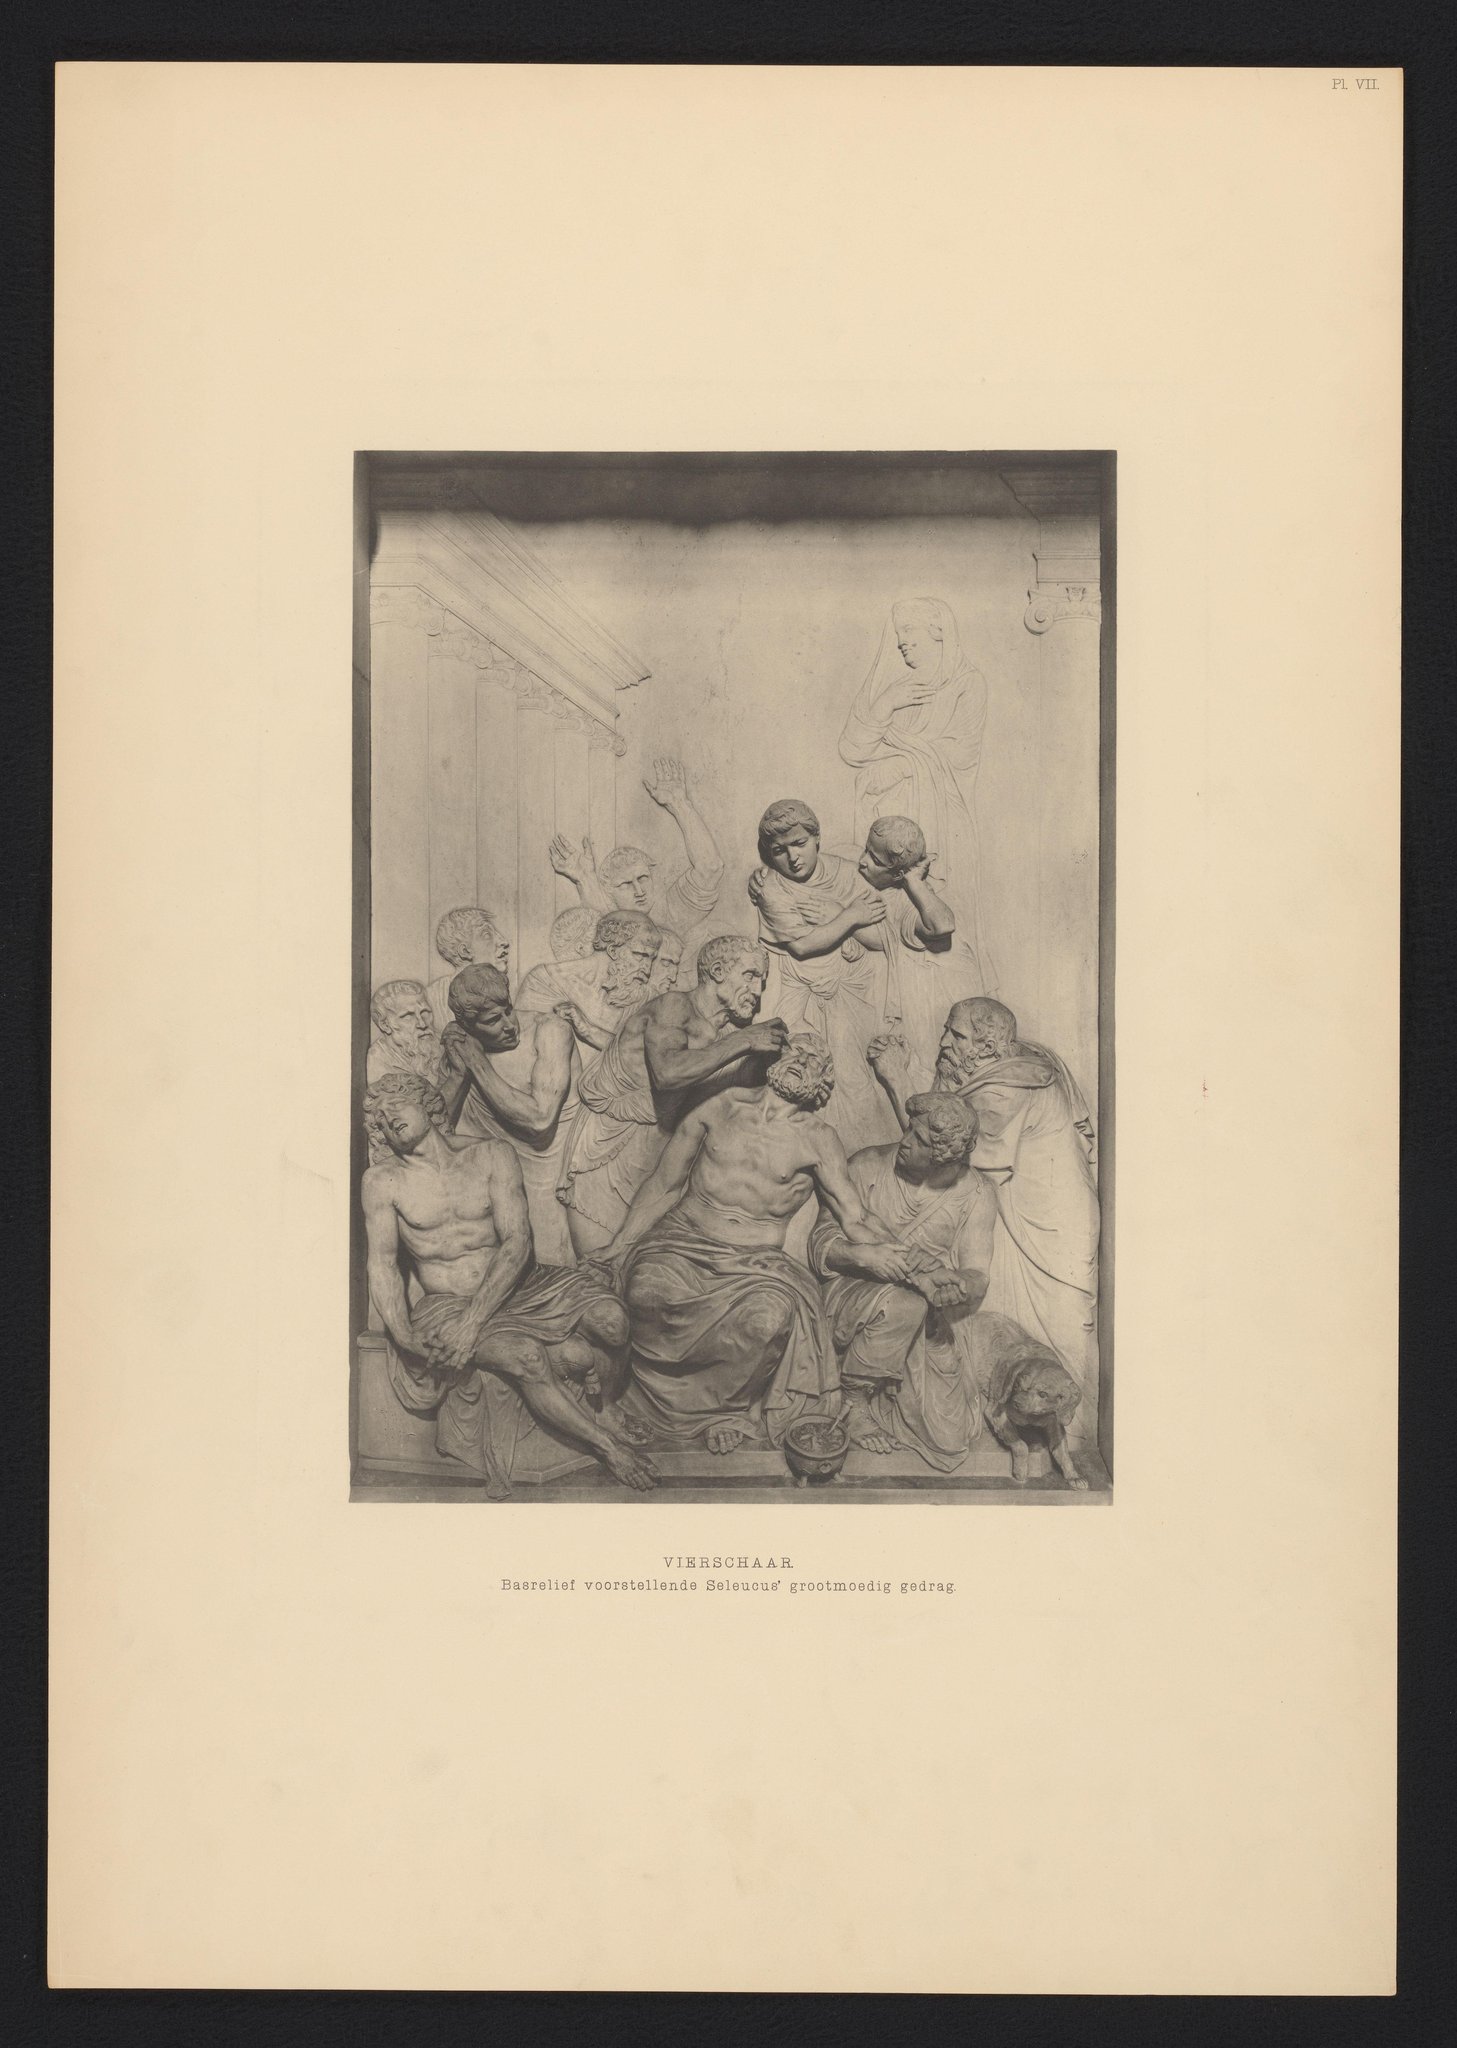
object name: photograph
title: Sculptuur De rechtspraak van Zaleucus door Quellinus in deVierschaar, Paleis op de Dam, Amsterdam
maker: Anonymous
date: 1899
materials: cardboard, paper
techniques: photograph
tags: palace, piece of sculpture, reproduction of a piece of sculpture, royal palace of amsterdam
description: Vierschaar. / Basreliëf voorstellende Seleucus' grootmoedig gedrag.